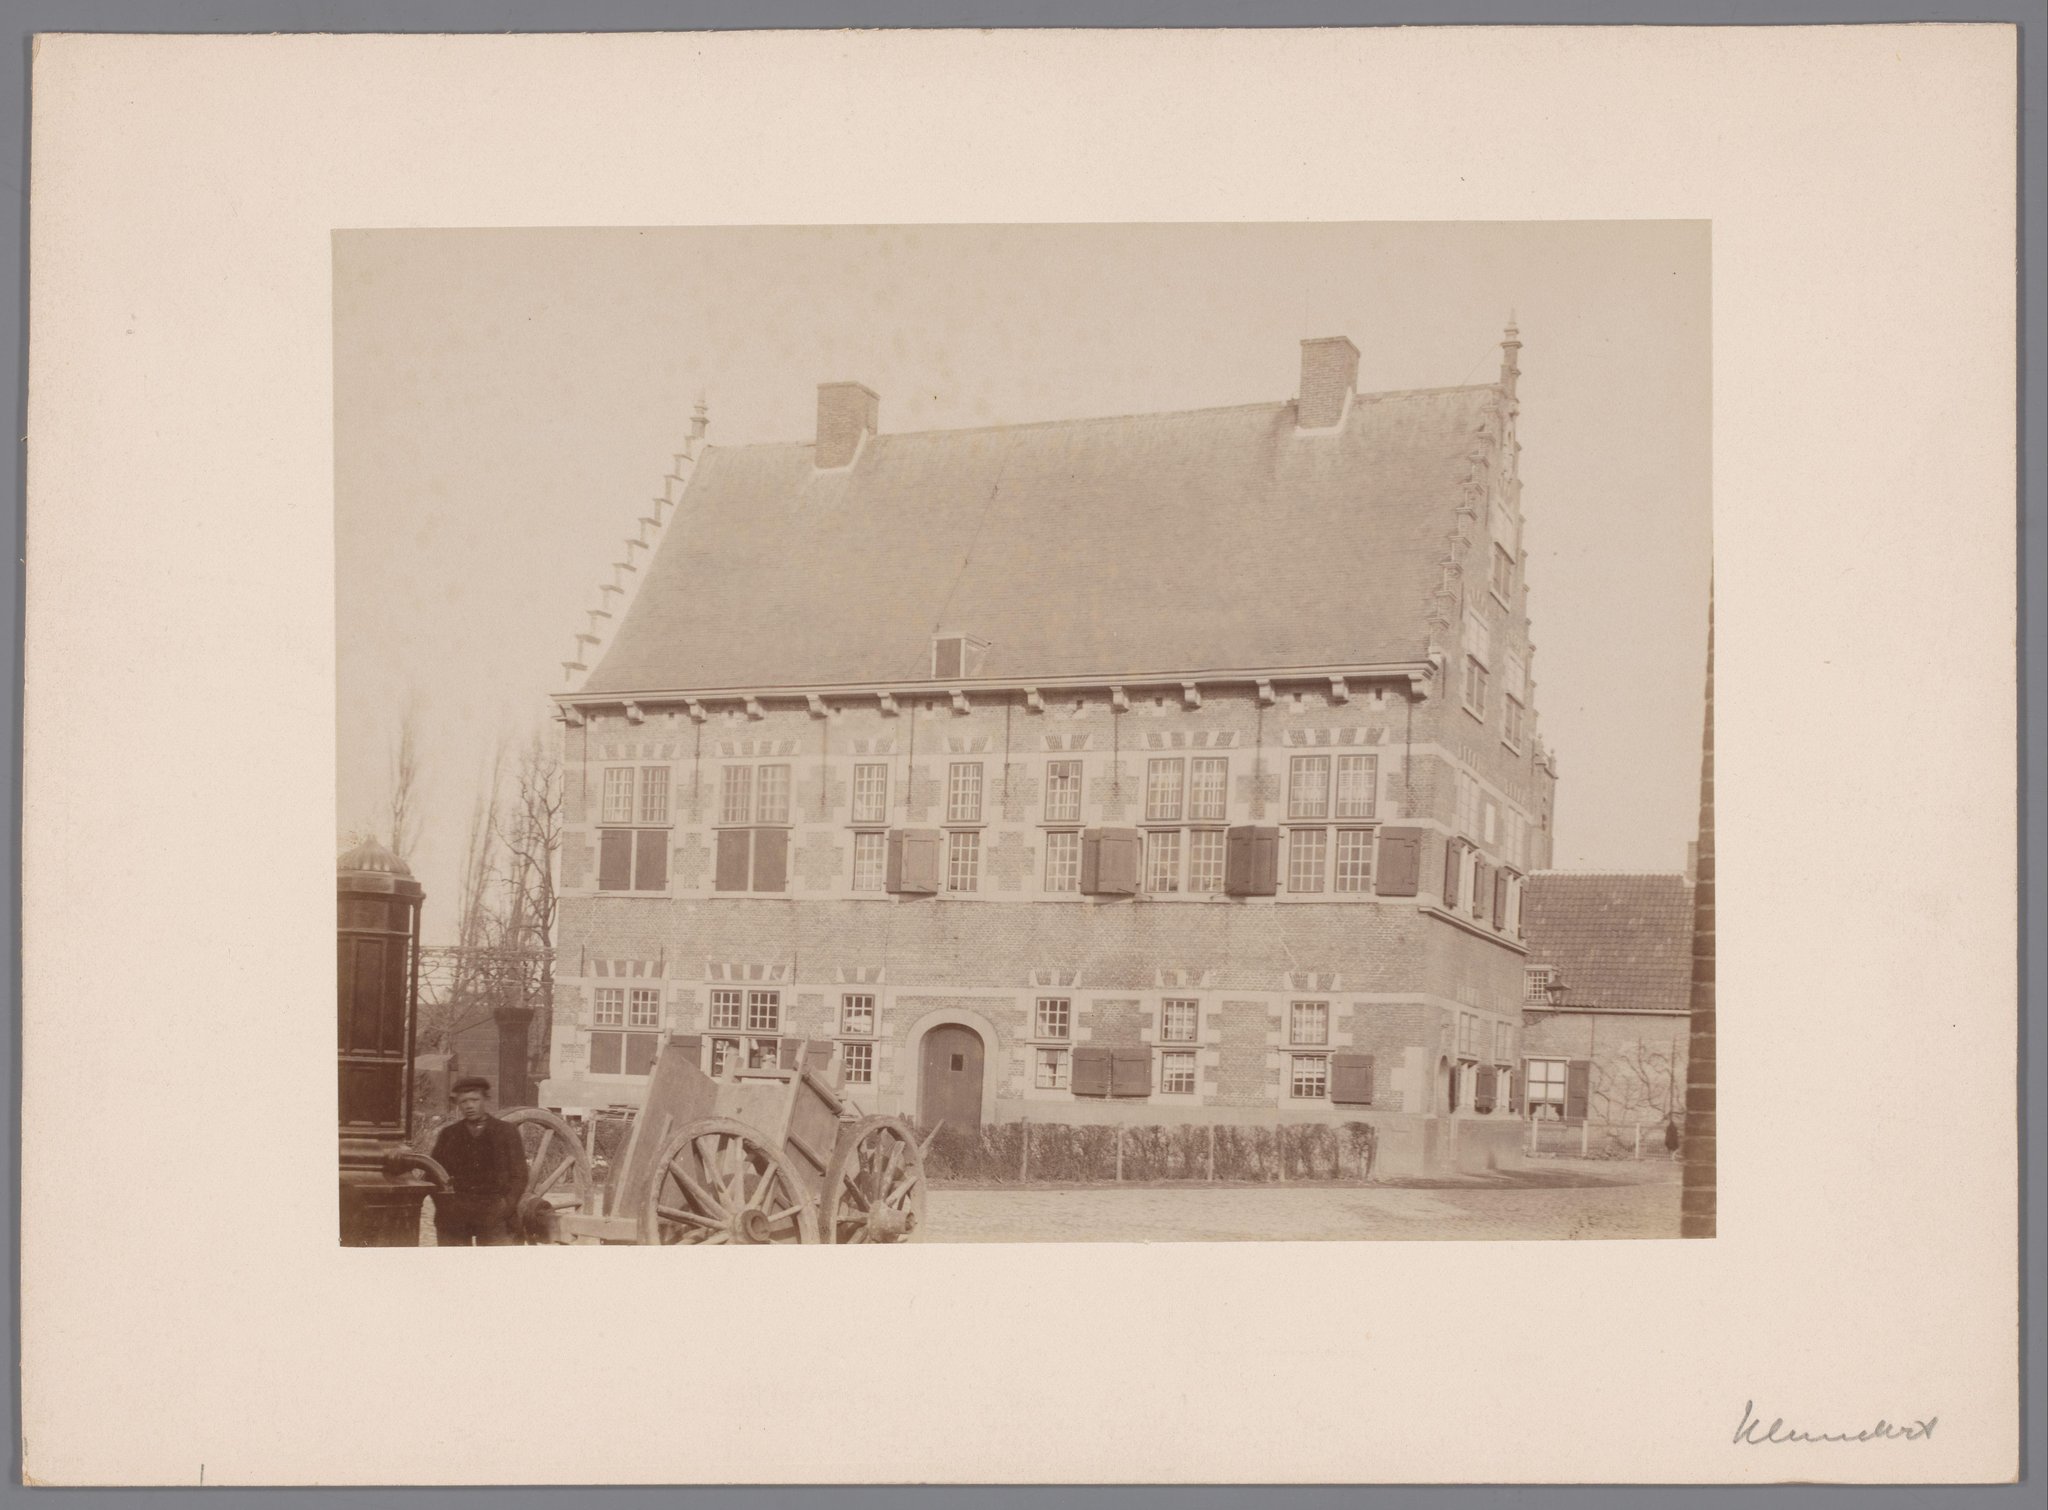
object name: photograph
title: Stadhuis te Klundert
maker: anoniem (monumentenzorg)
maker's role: fotograaf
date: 1890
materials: cardboard, photographic support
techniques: albumen print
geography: klundert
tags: townhall, klundert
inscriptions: annotation: ‘Klundert’, annotation: ‘Klundert/ Raadhuis 1621’